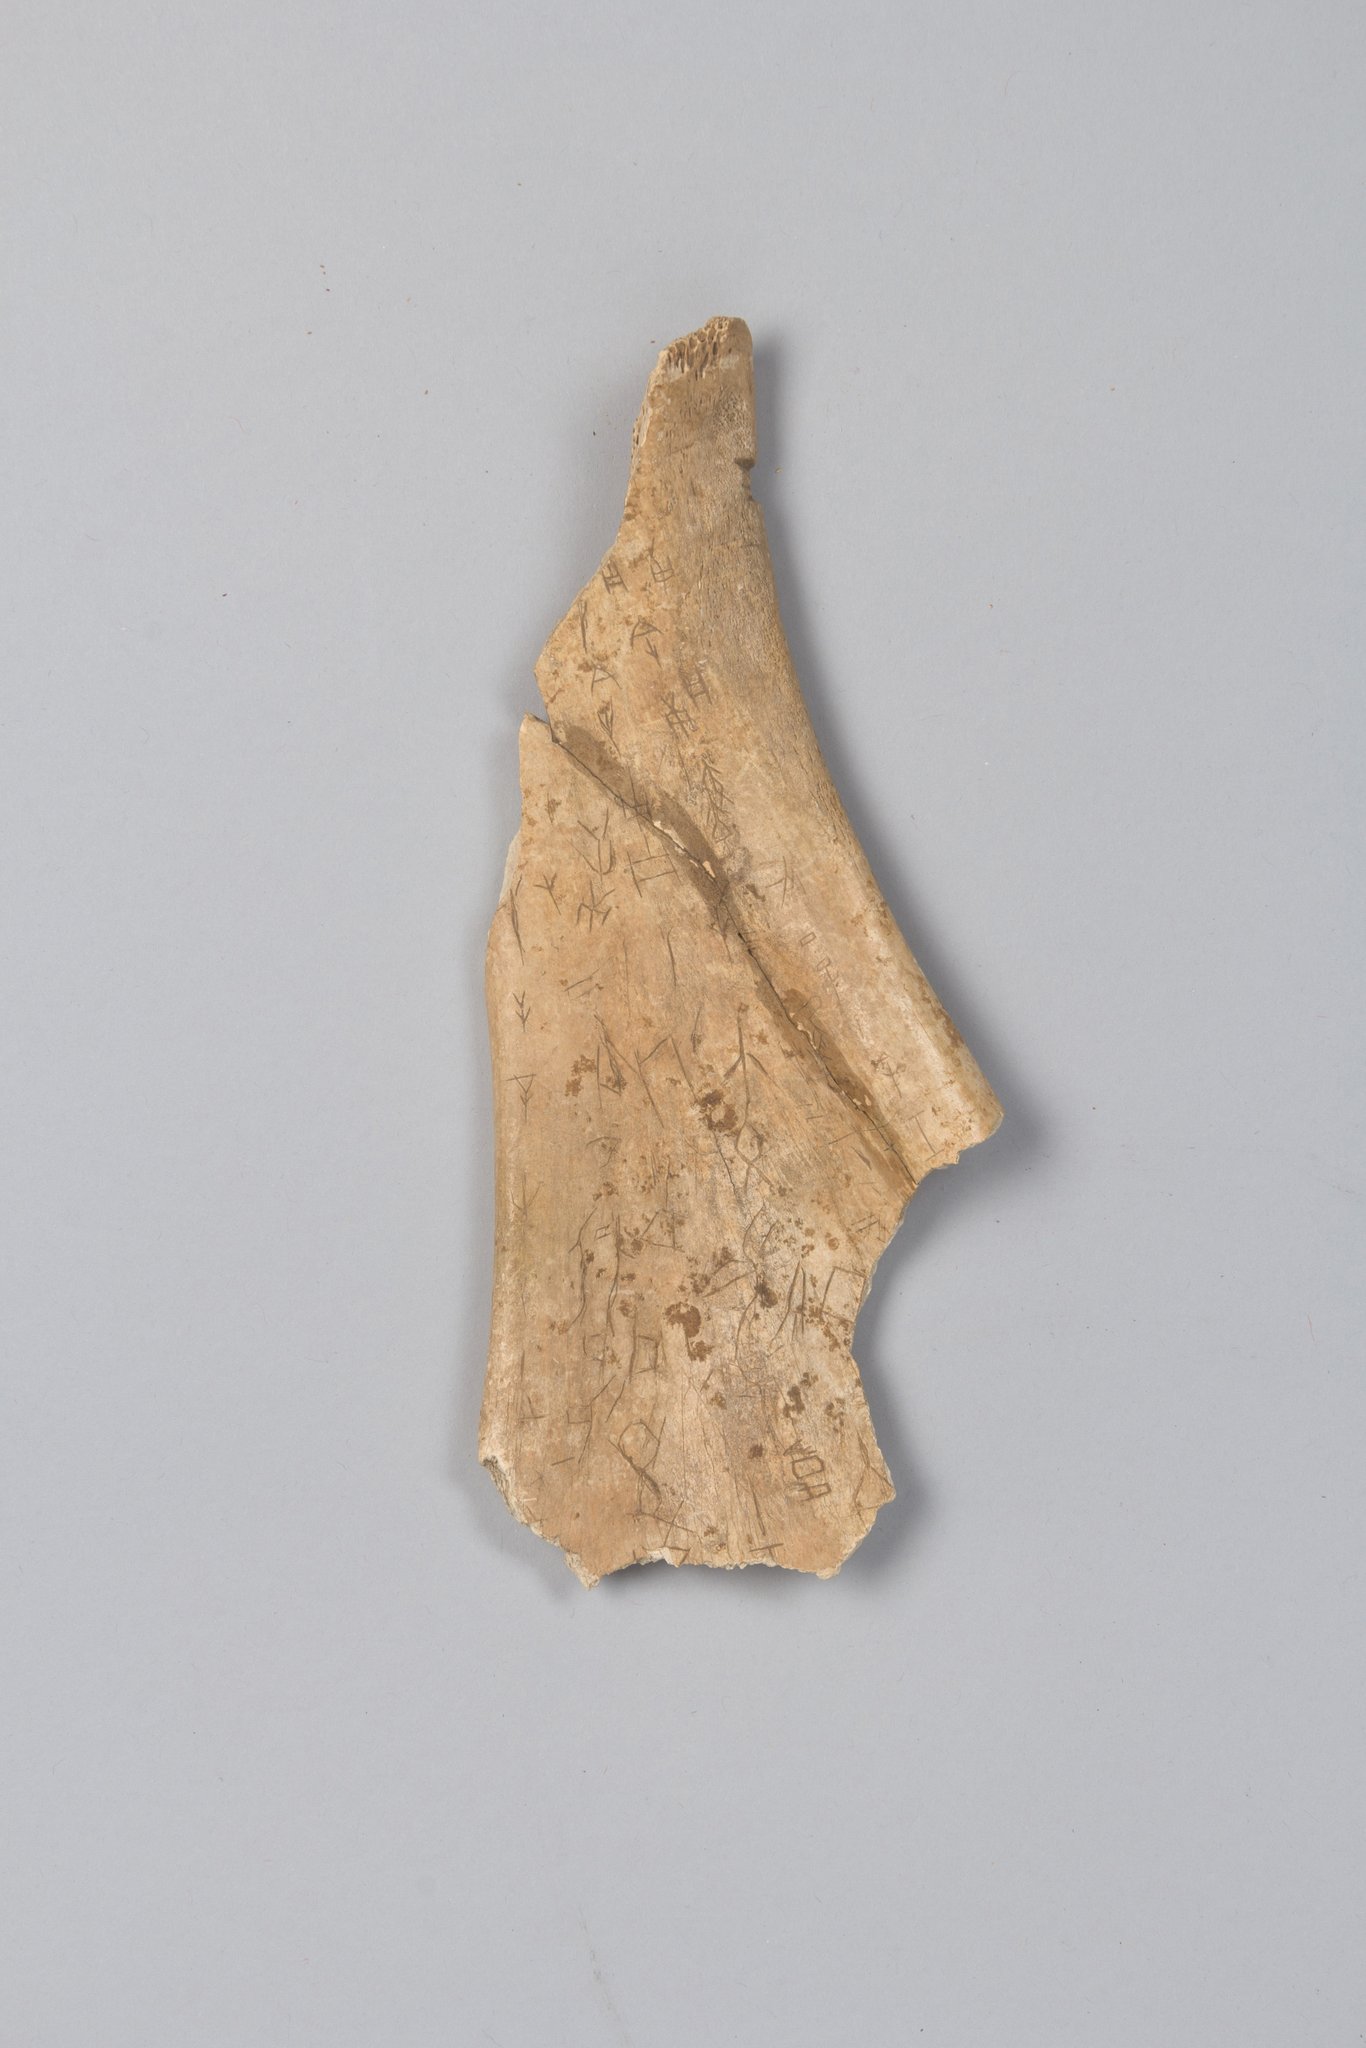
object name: oracle bone fragment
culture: chinese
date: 1610-1036 BCE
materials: bone